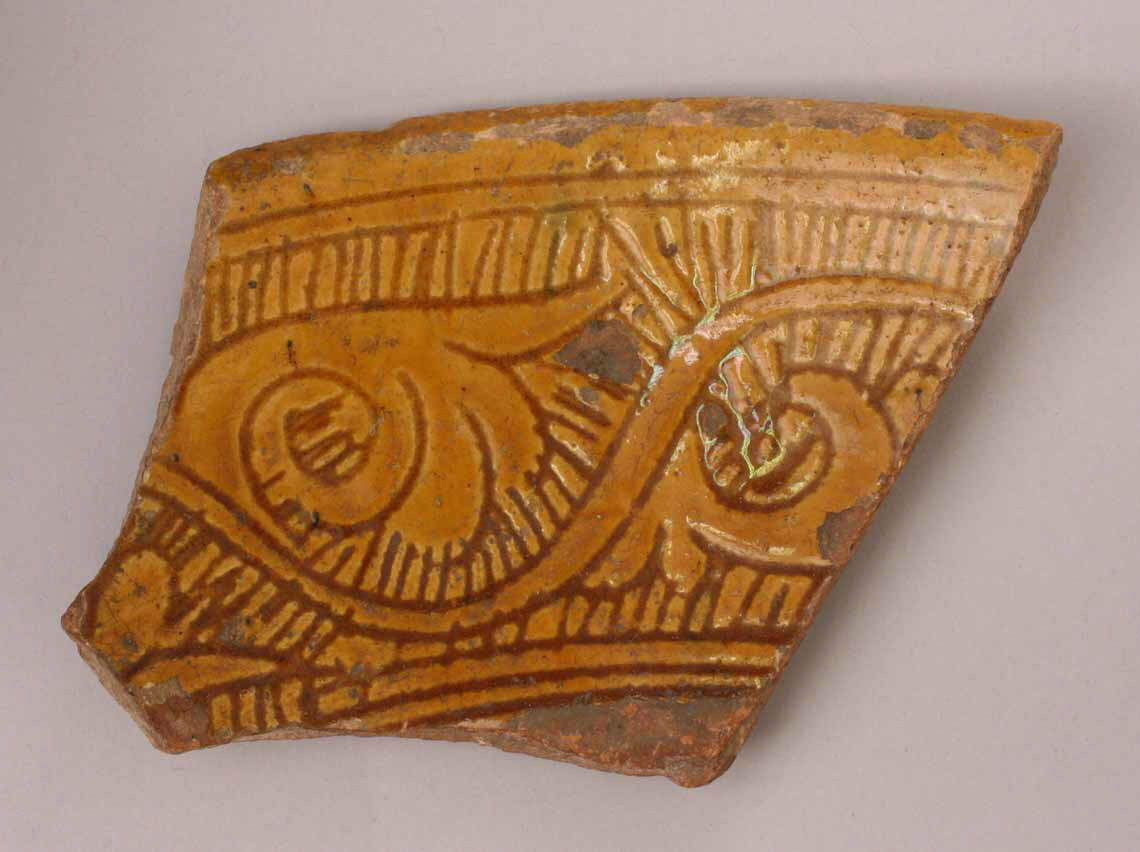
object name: ceramic fragment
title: Fragment of a Bowl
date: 1301-1500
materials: earthenware, glaze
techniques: coloring, incising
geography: egypt